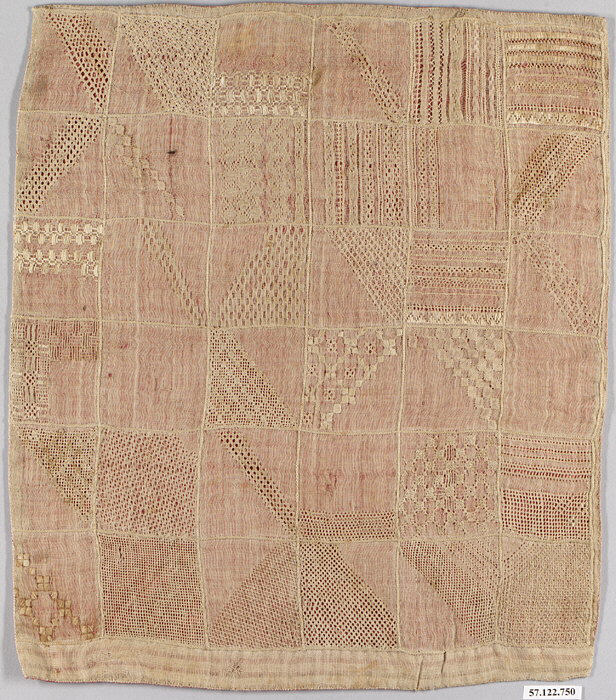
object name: sampler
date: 1801-1900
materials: linen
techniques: embroidery, lace